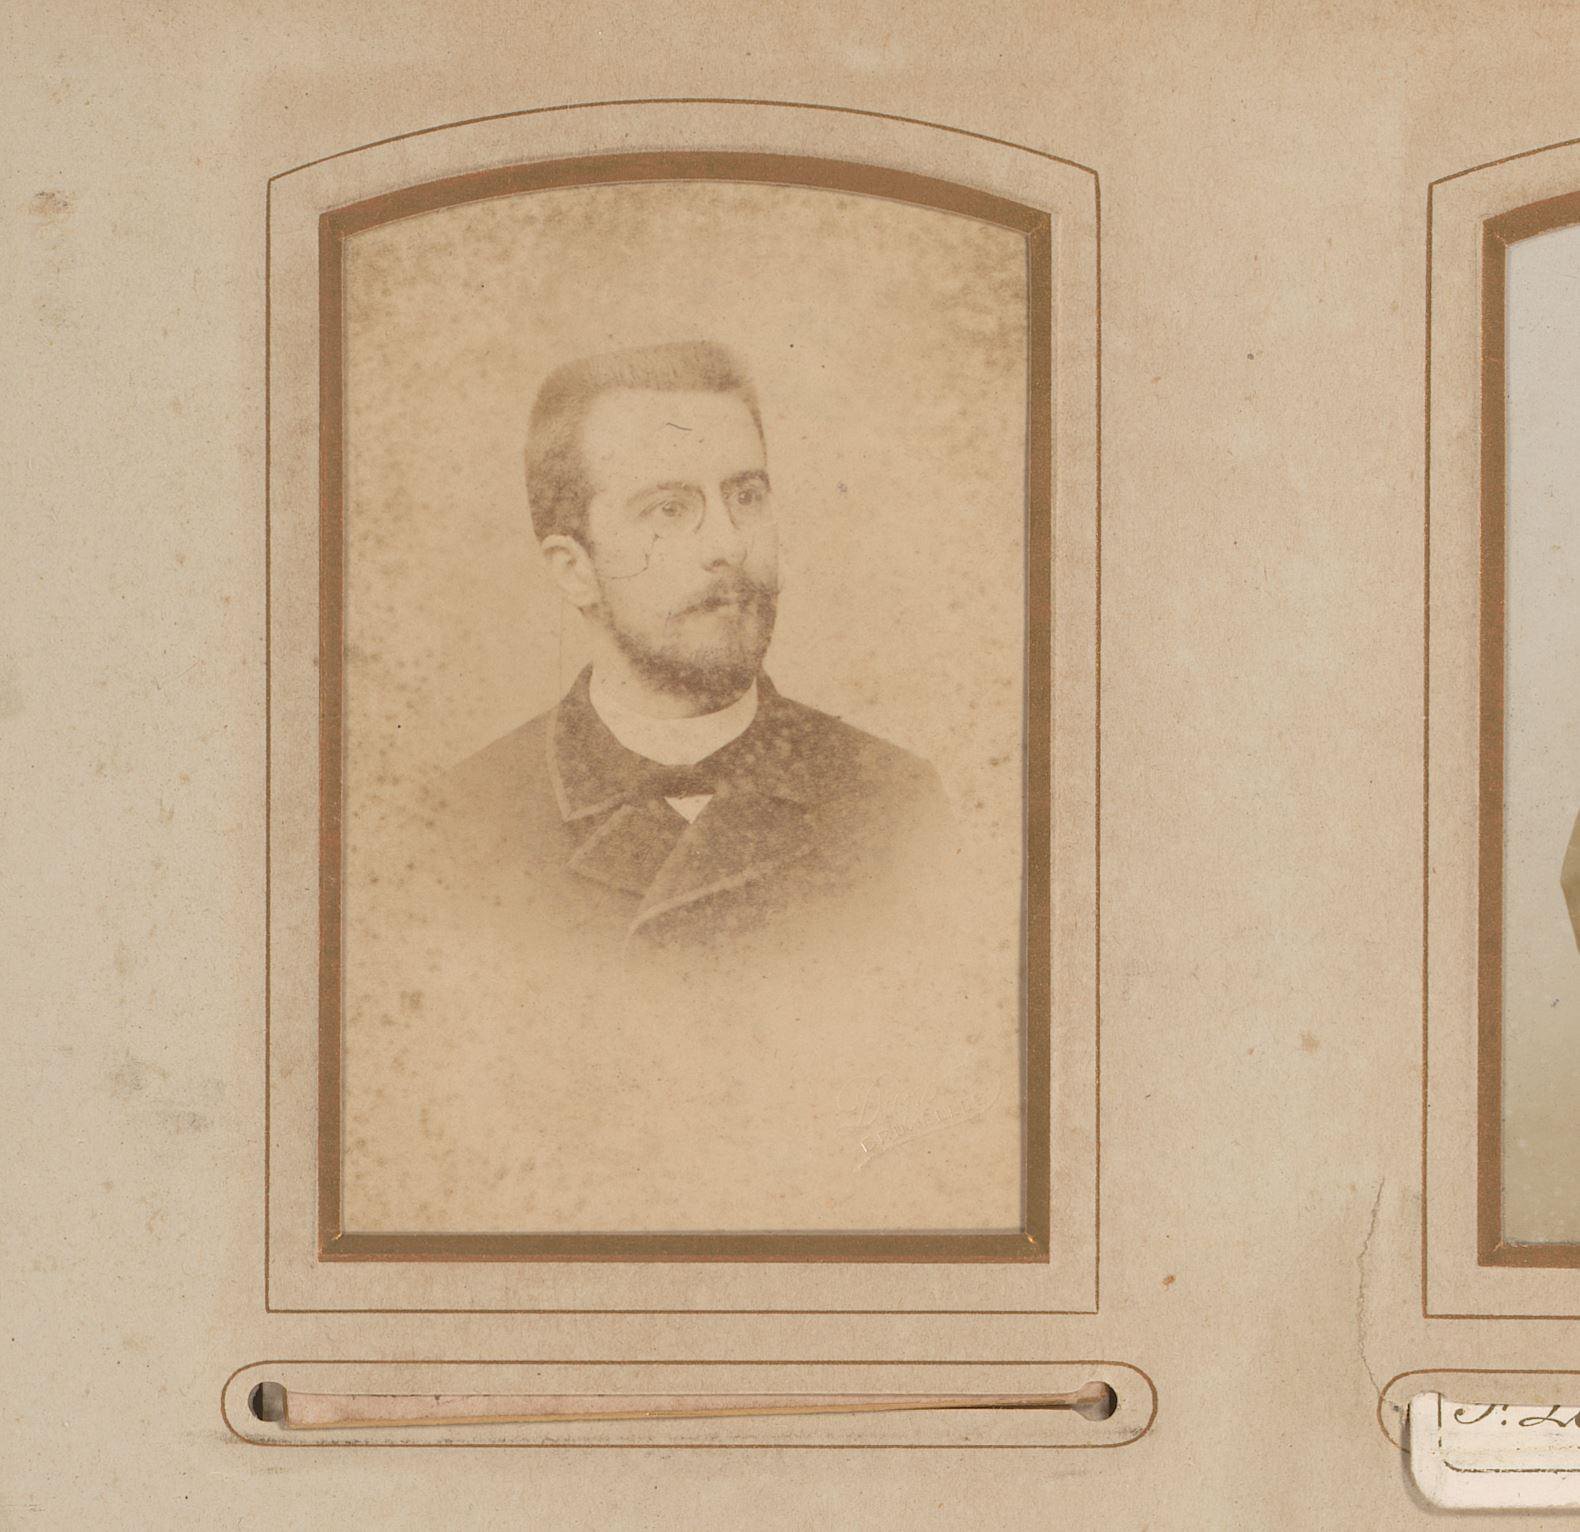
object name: album leaf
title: Portret van een man met baard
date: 1888-1890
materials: cardboard, photographic support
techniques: albumen print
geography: brussels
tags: historical persons, beard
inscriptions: inscription: ‘DUPONT/ 75, rue Neuve/ BRUXELLES/ MÉDAILLES:/ Utrechts 1876/ Paris 1878./ Gand 1880./ Bruxelles 1880./ Paris Electricité 1881./ Lille 1882./ Amsterdam (Or) 1883./ Nice (Or) 1884./ Anvers hors concours 1885./ Bruxelles (Or) 1888’